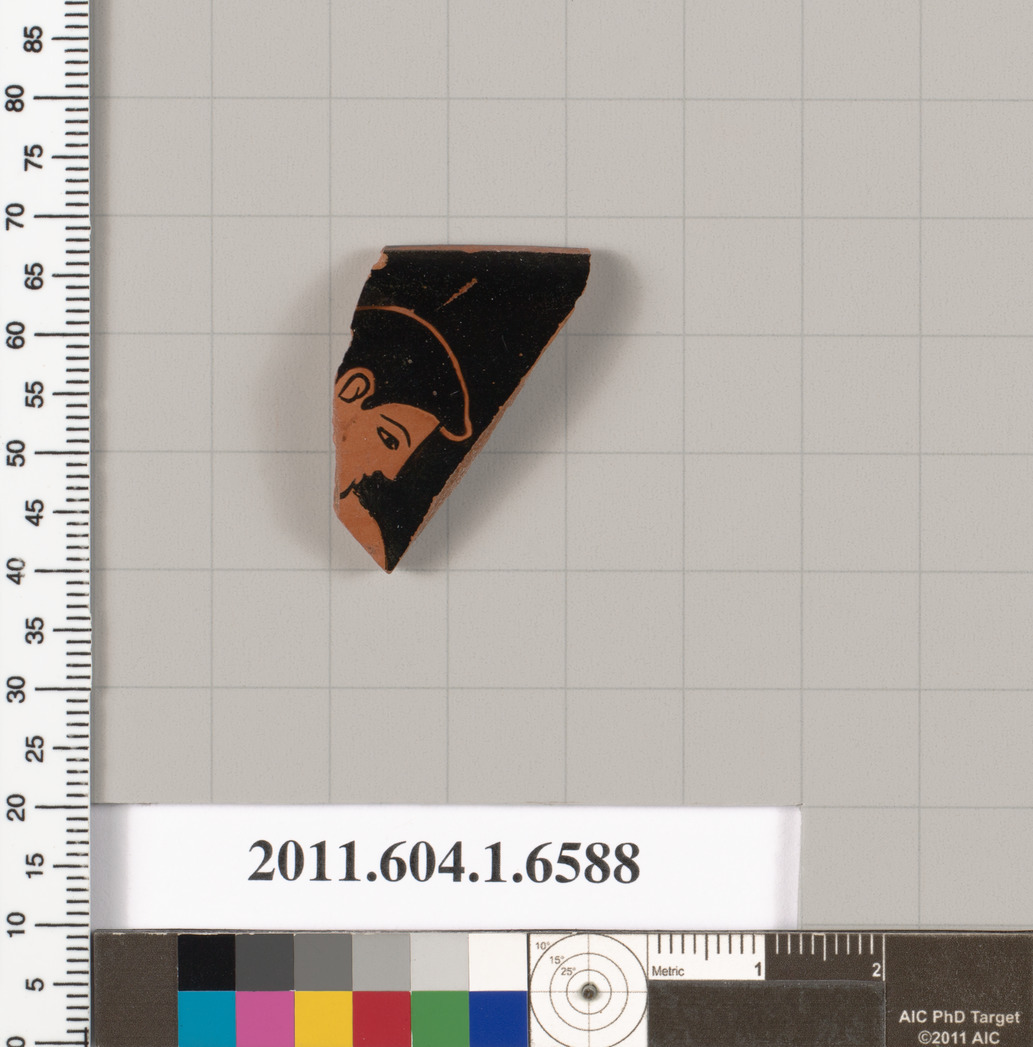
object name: kylix fragment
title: Terracotta rim fragment of a kylix (drinking cup)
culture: greek, attic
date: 490-480 BCE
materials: terracotta